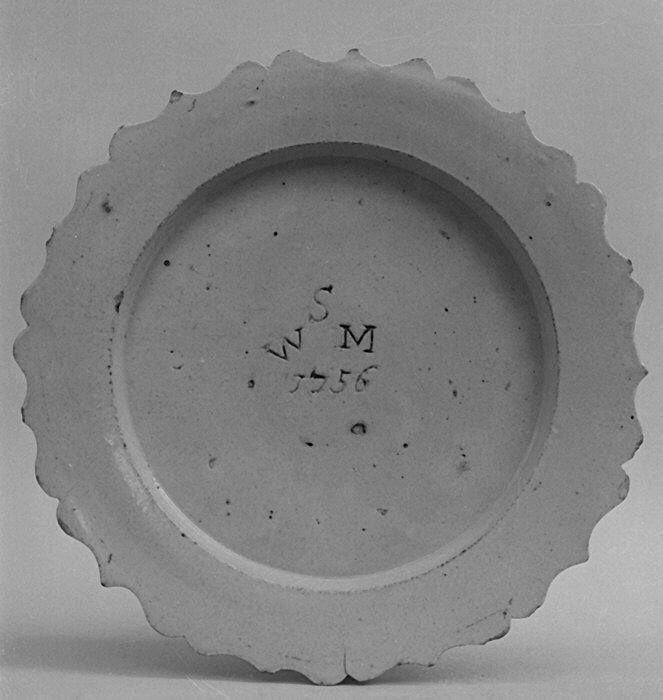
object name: plate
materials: stoneware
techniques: salt glaze